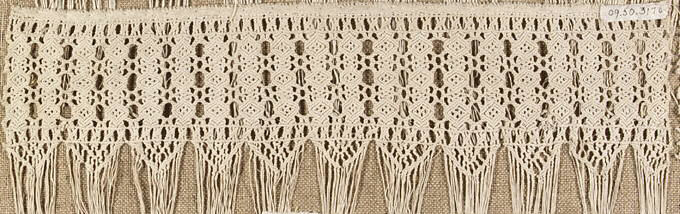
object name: fragment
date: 1701-1800